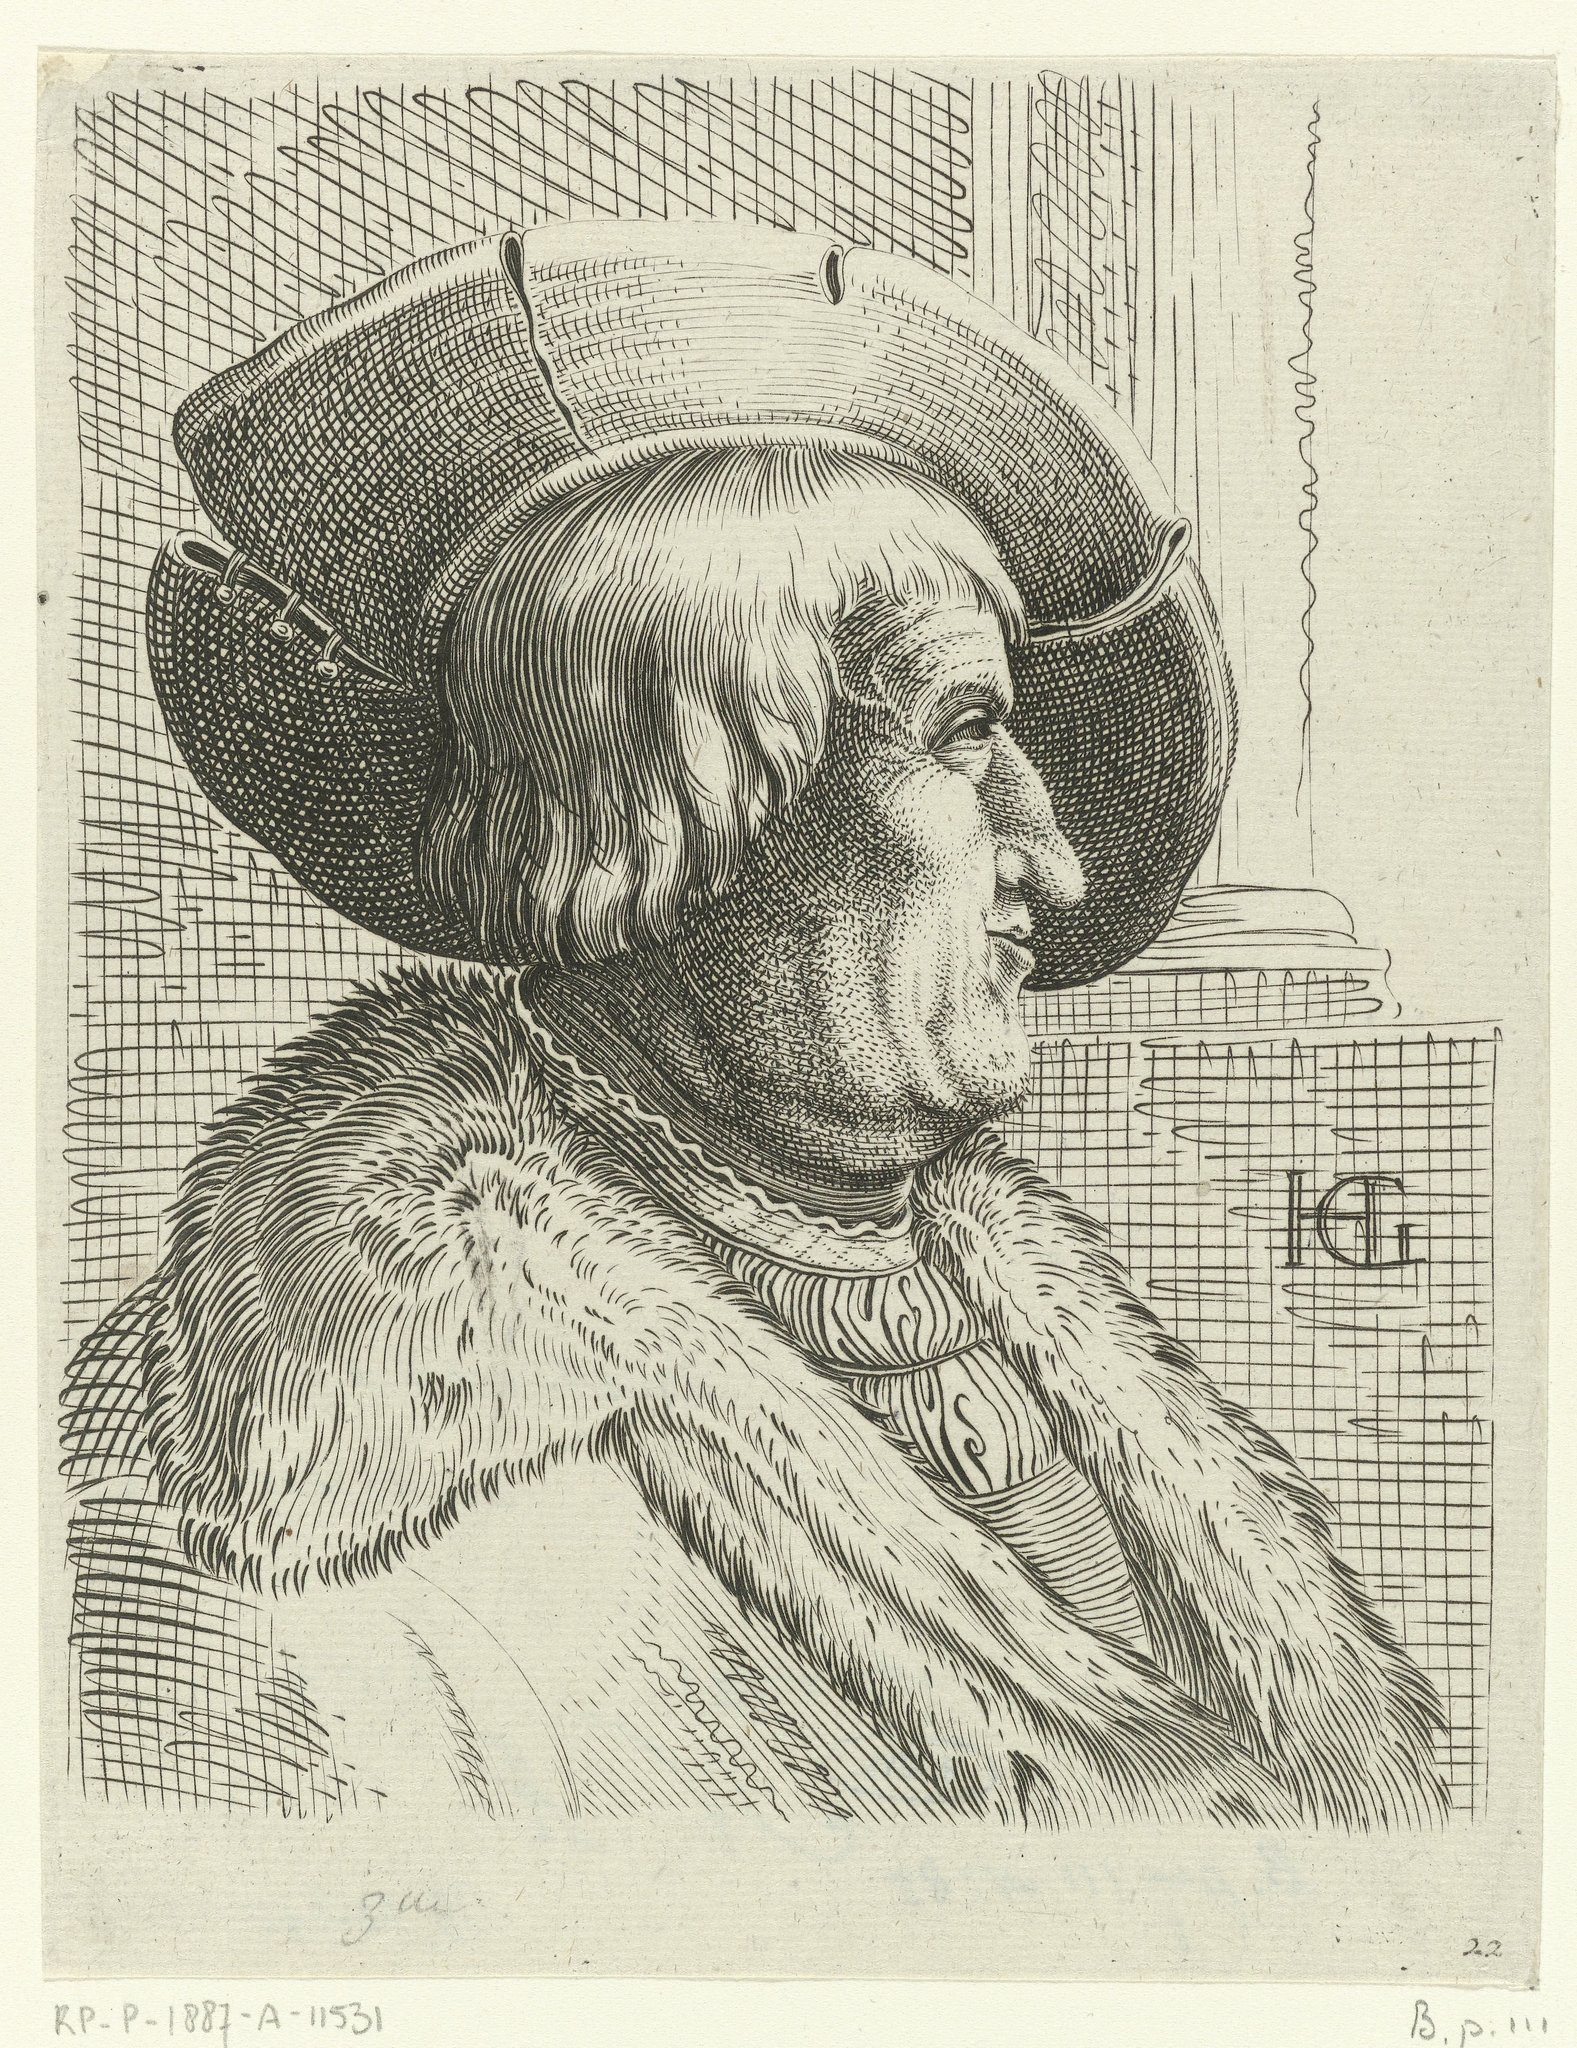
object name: print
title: Portret van een oude man in profiel met hoed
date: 1597-1702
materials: paper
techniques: engraving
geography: netherlands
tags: head-gear: hat (+ men's clothes)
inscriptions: collector's mark: Lugt 2228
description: Fantasieportret in profiel van een oude man met een hoed op en een mantel met bontkraag aan, op de rechterzijde gezien. Rechtsonder genummerd: 22.